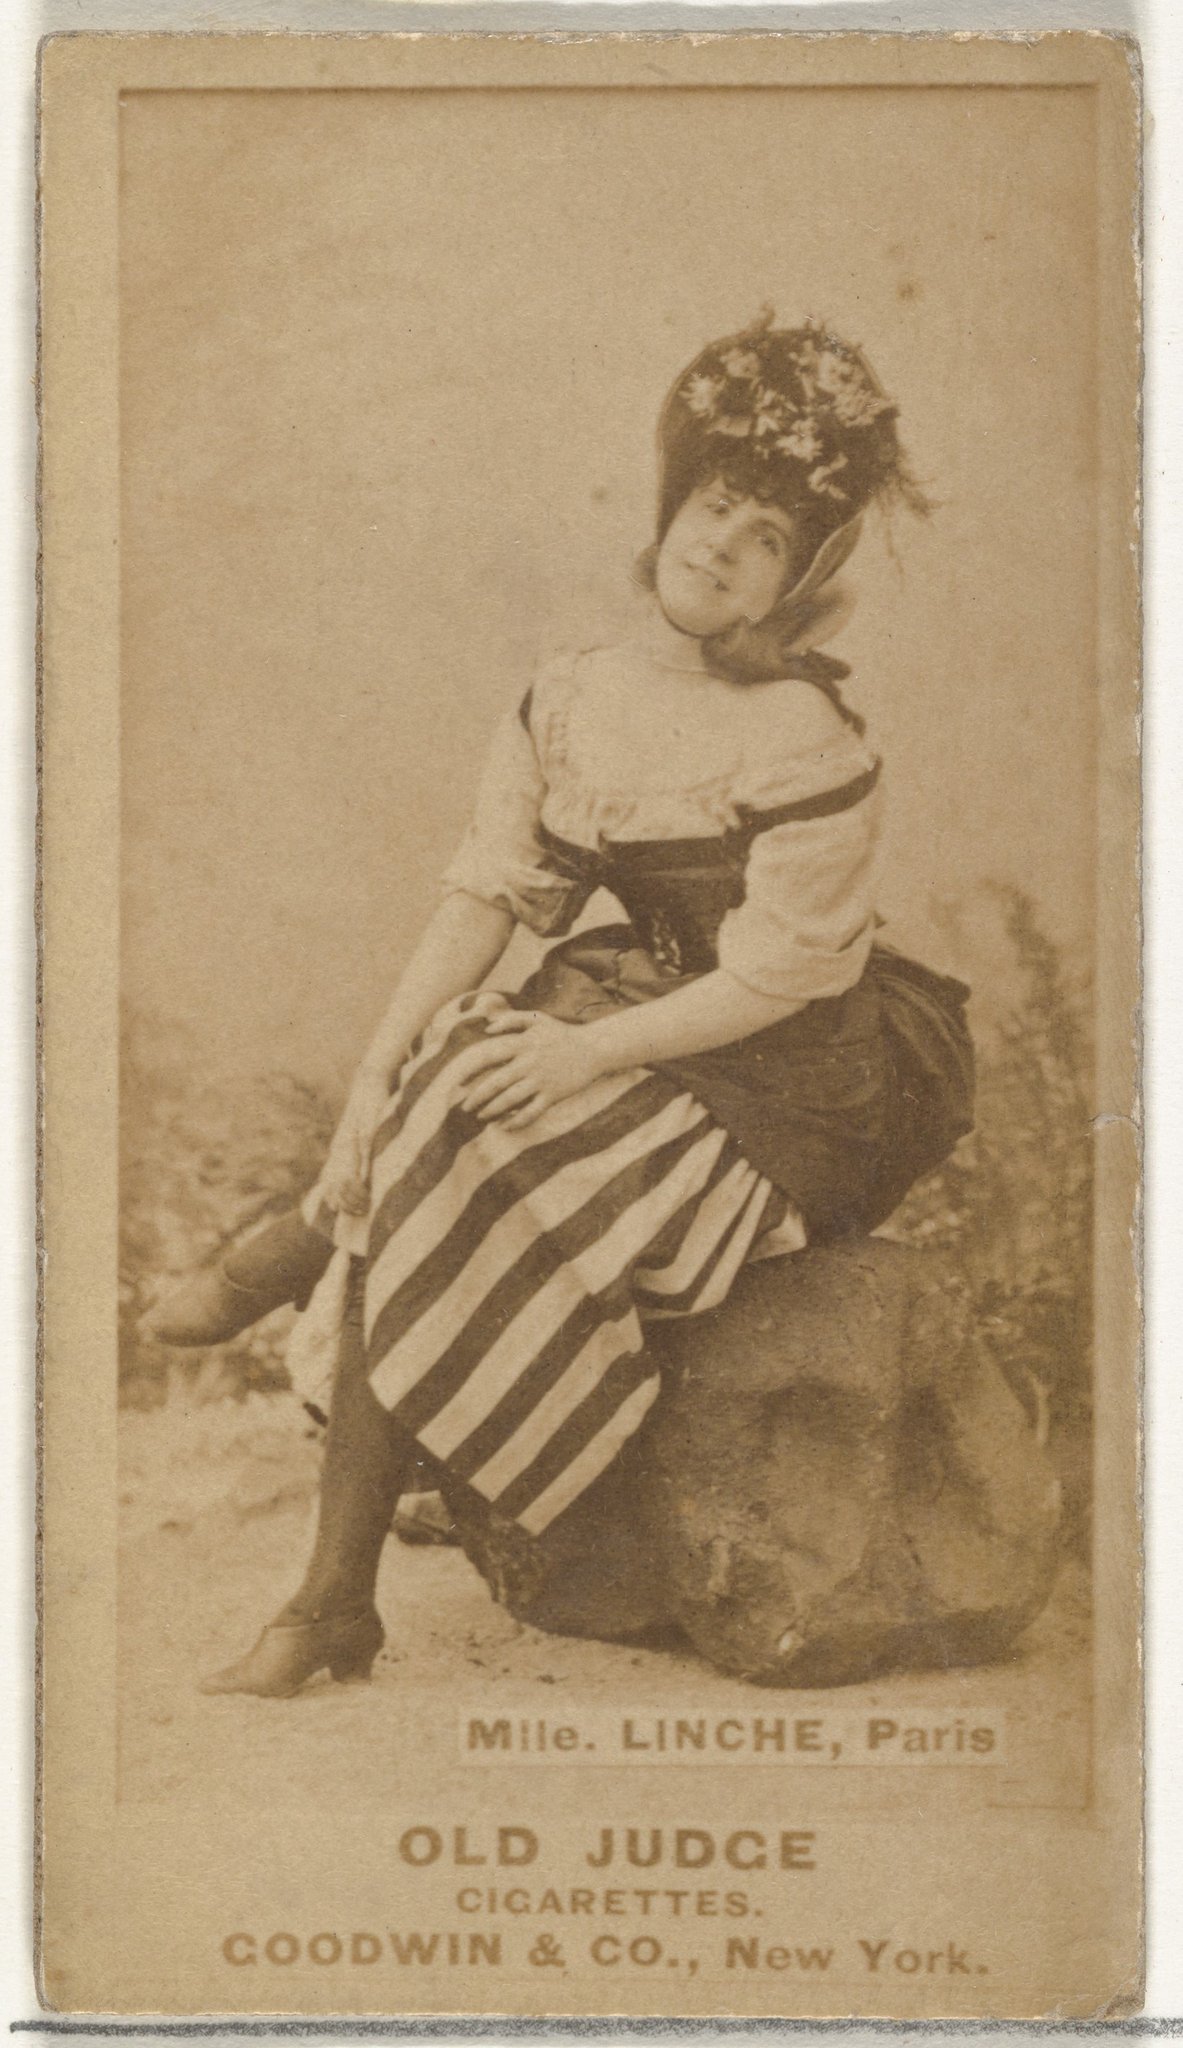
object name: photograph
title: Mlle. Linche, Paris, from the Actors and Actresses series (N171) for Old Judge Cigarettes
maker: goodwin & company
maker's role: publisher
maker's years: 1850-1950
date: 1886-1890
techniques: albumen silver print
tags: portraits,women,actresses